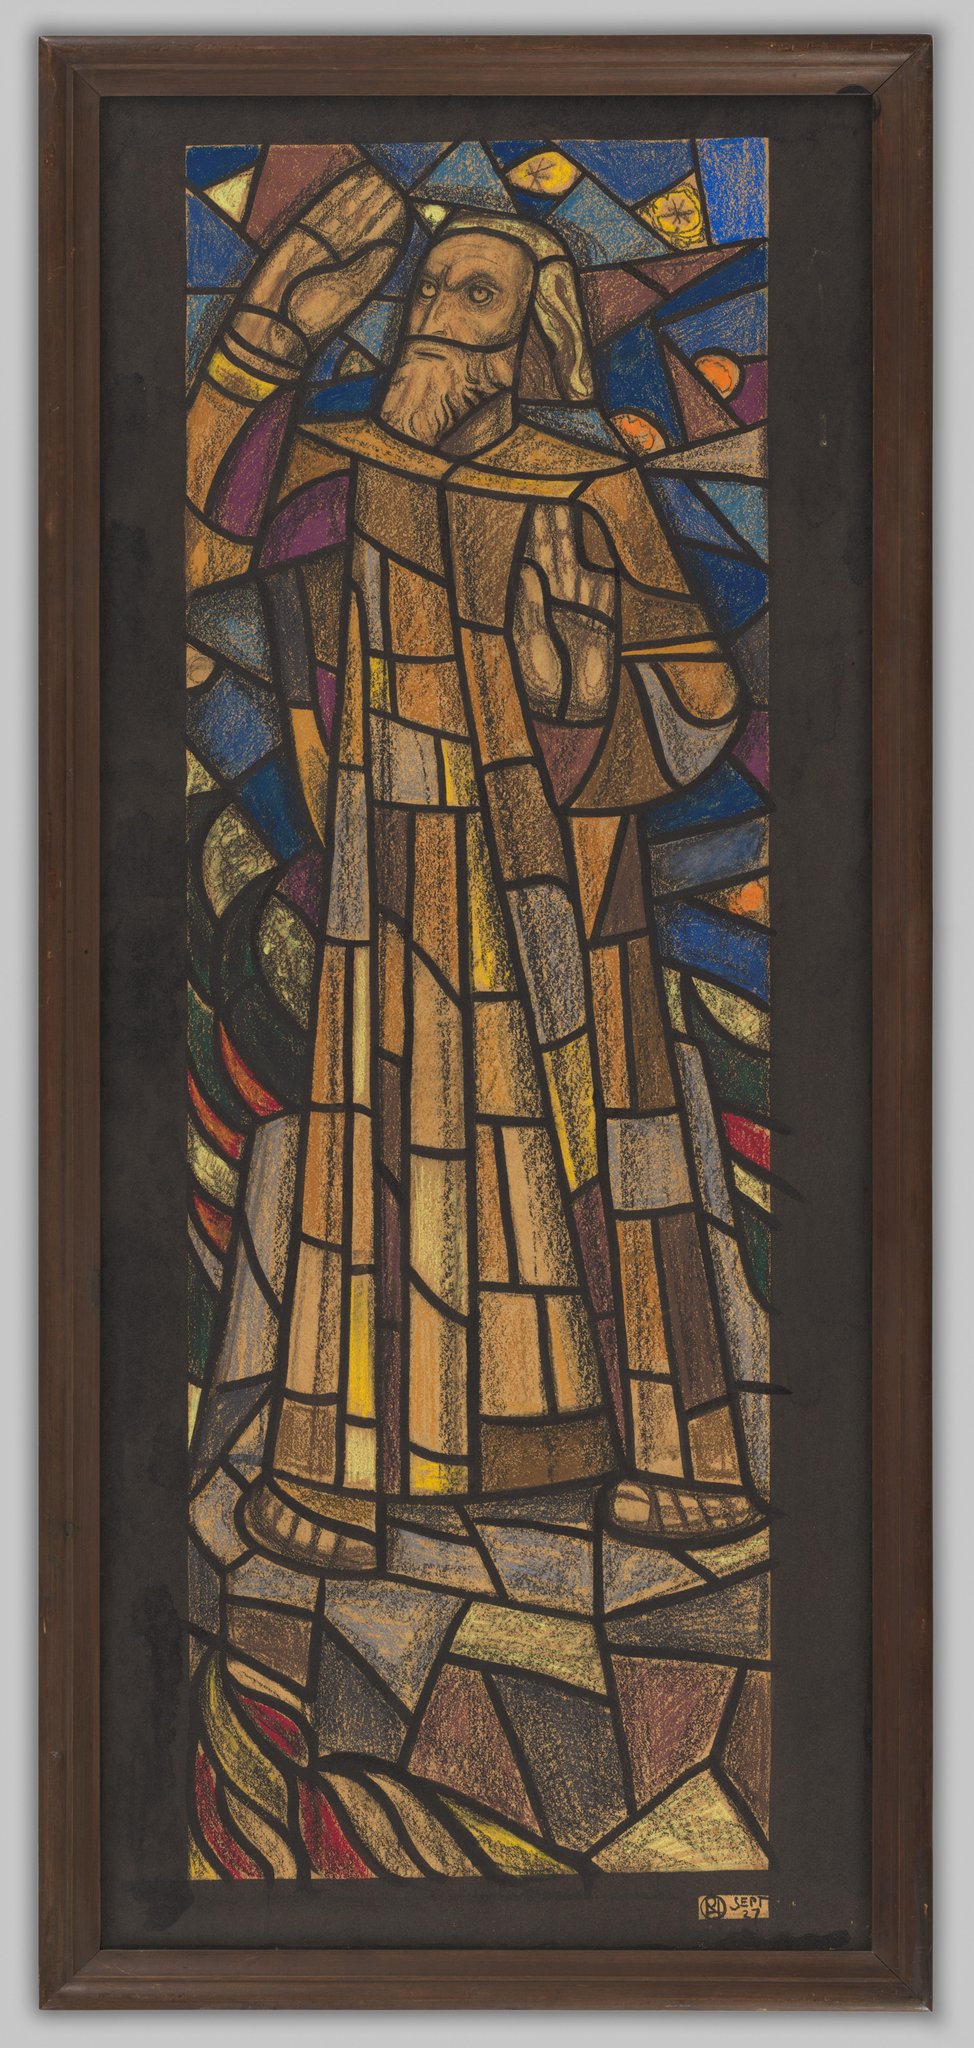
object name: drawing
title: Ontwerp voor raam in het Amsterdams Lyceum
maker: richard nicolaüs roland holst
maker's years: 1868-1938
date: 1909-1927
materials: cardboard, chalk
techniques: brush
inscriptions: monogram: ‘RNRH’, date: ‘sept. '27’